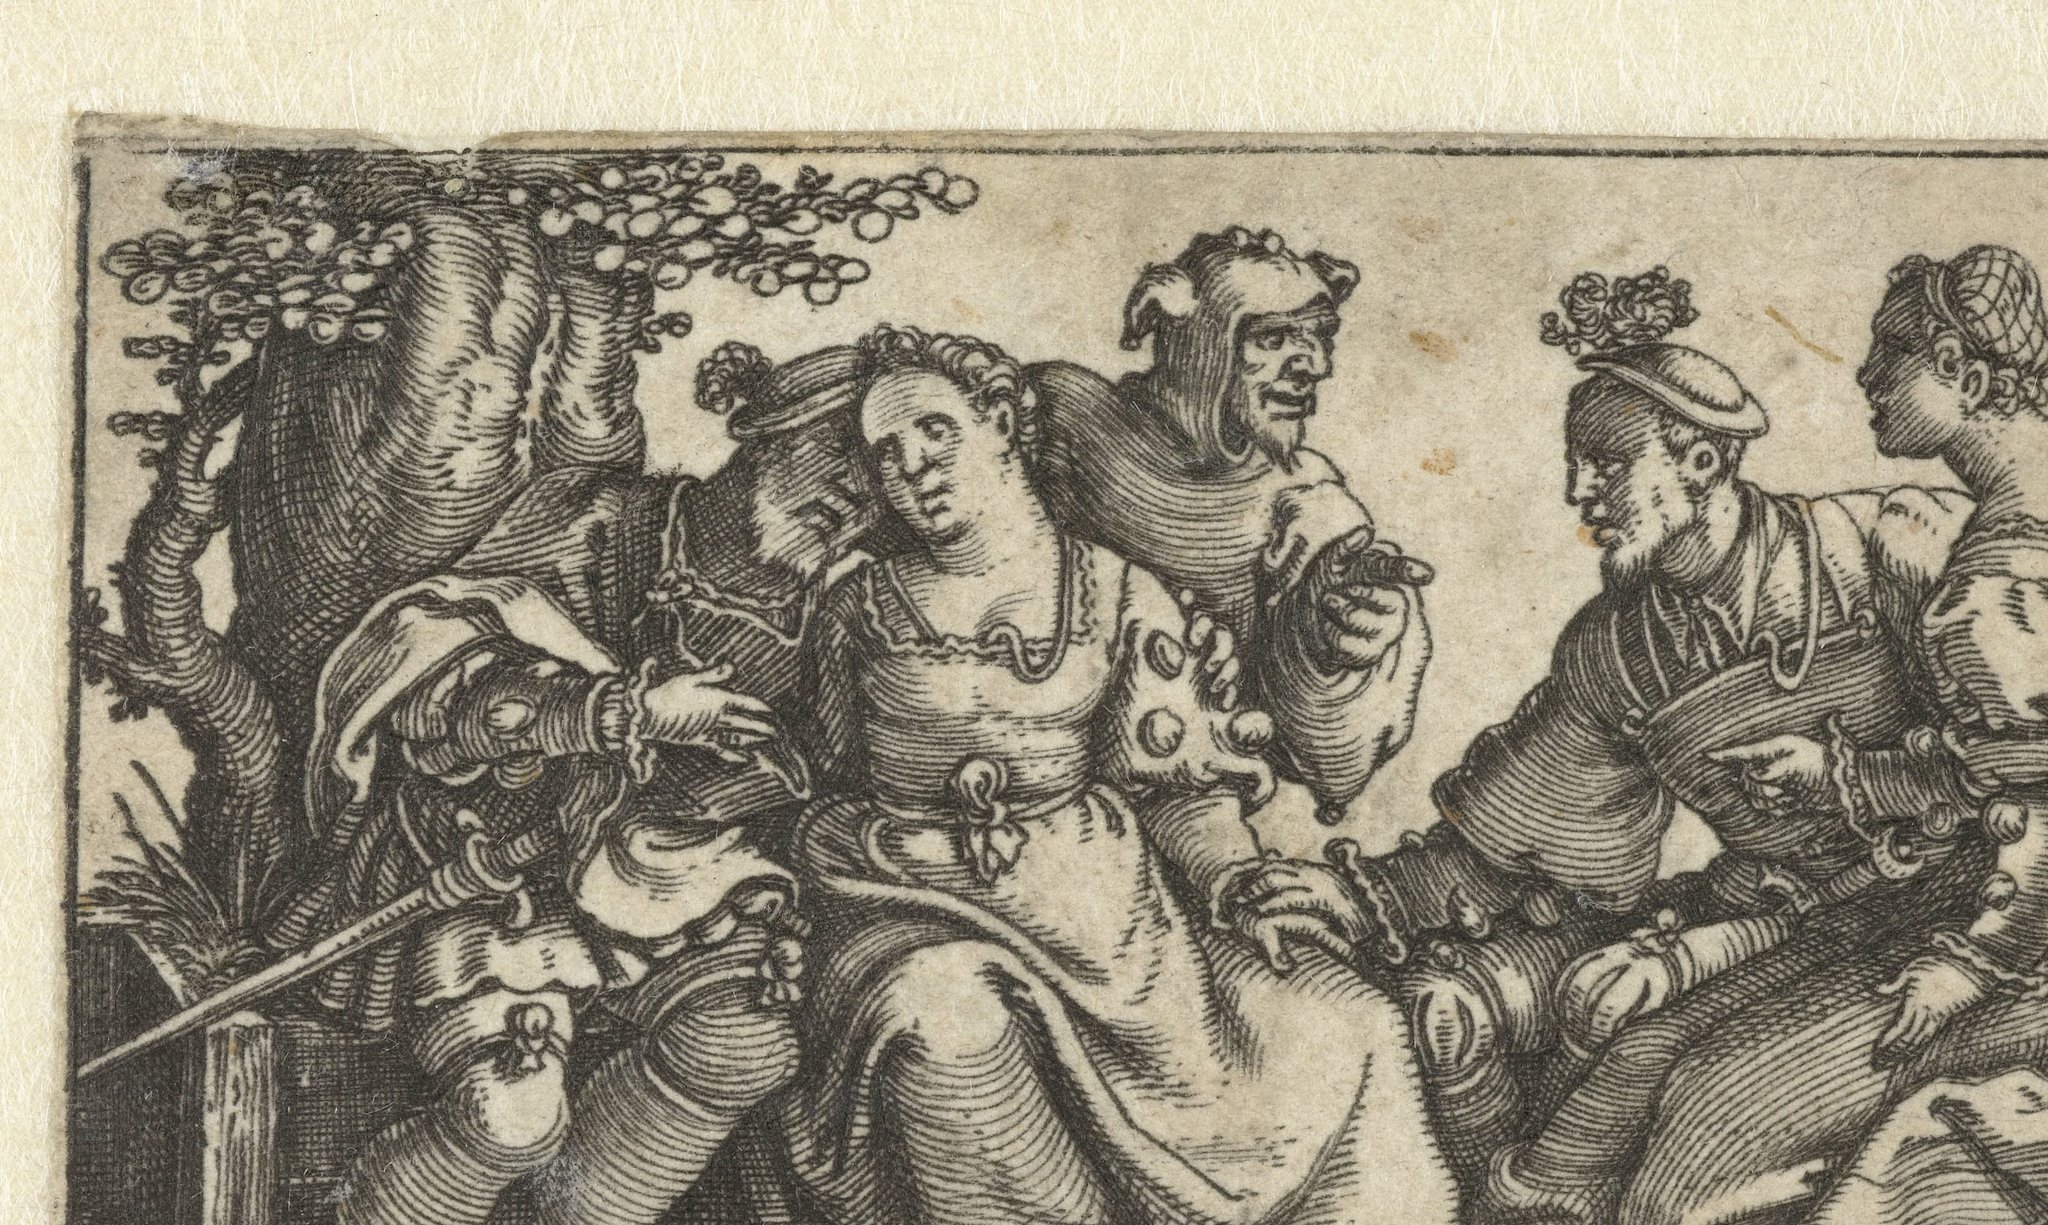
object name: print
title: Twee liefdesparen en een nar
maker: hans sebald beham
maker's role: designer, draughtsman, print maker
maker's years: 1500-1550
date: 1535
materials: paper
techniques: engraving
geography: frankfurt am main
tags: buffoon (in general) (german: 'schalksnarr'), lovers; courting, flirting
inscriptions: collector's mark: Lugt 2228a